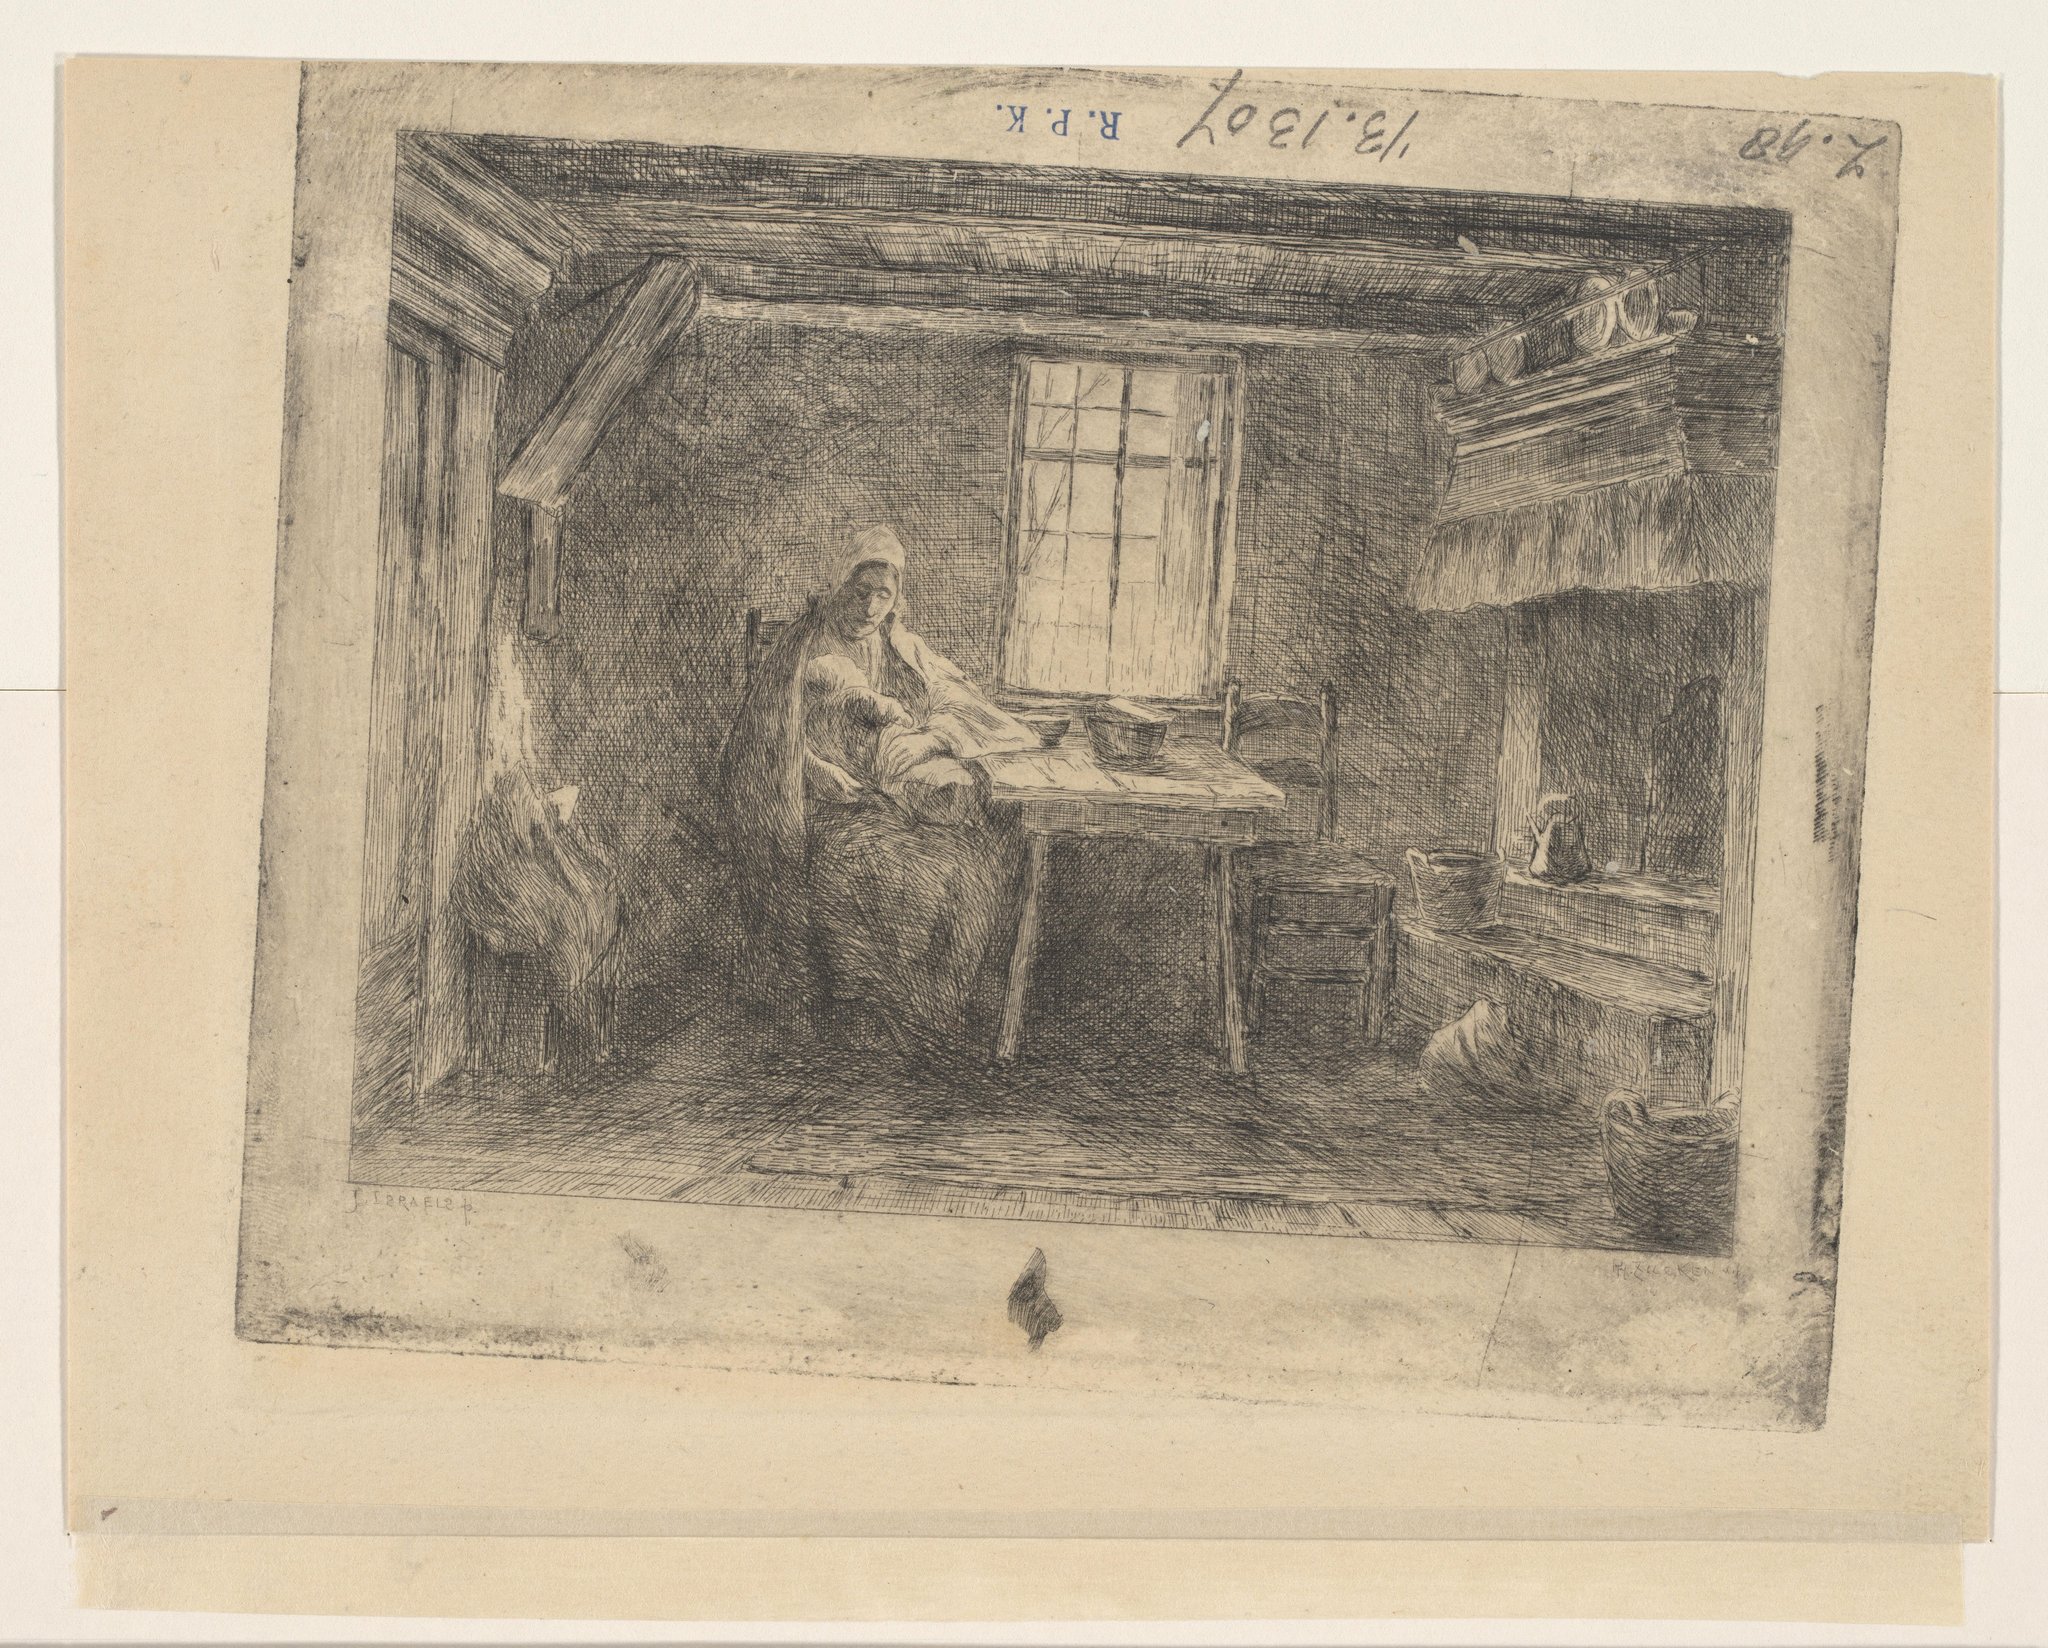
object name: print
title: l'enfant endormi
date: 1888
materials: paper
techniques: etching, intaglio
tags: mother and baby or young child, sleeping; unconsciousness, farm (building) - aa - civic architecture: inside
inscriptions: collector's mark: Lugt 2233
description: Prent is ook gebruikt in: Memorial catalogue of the French and Dutch. Edinburgh: David Douglas, 1888.